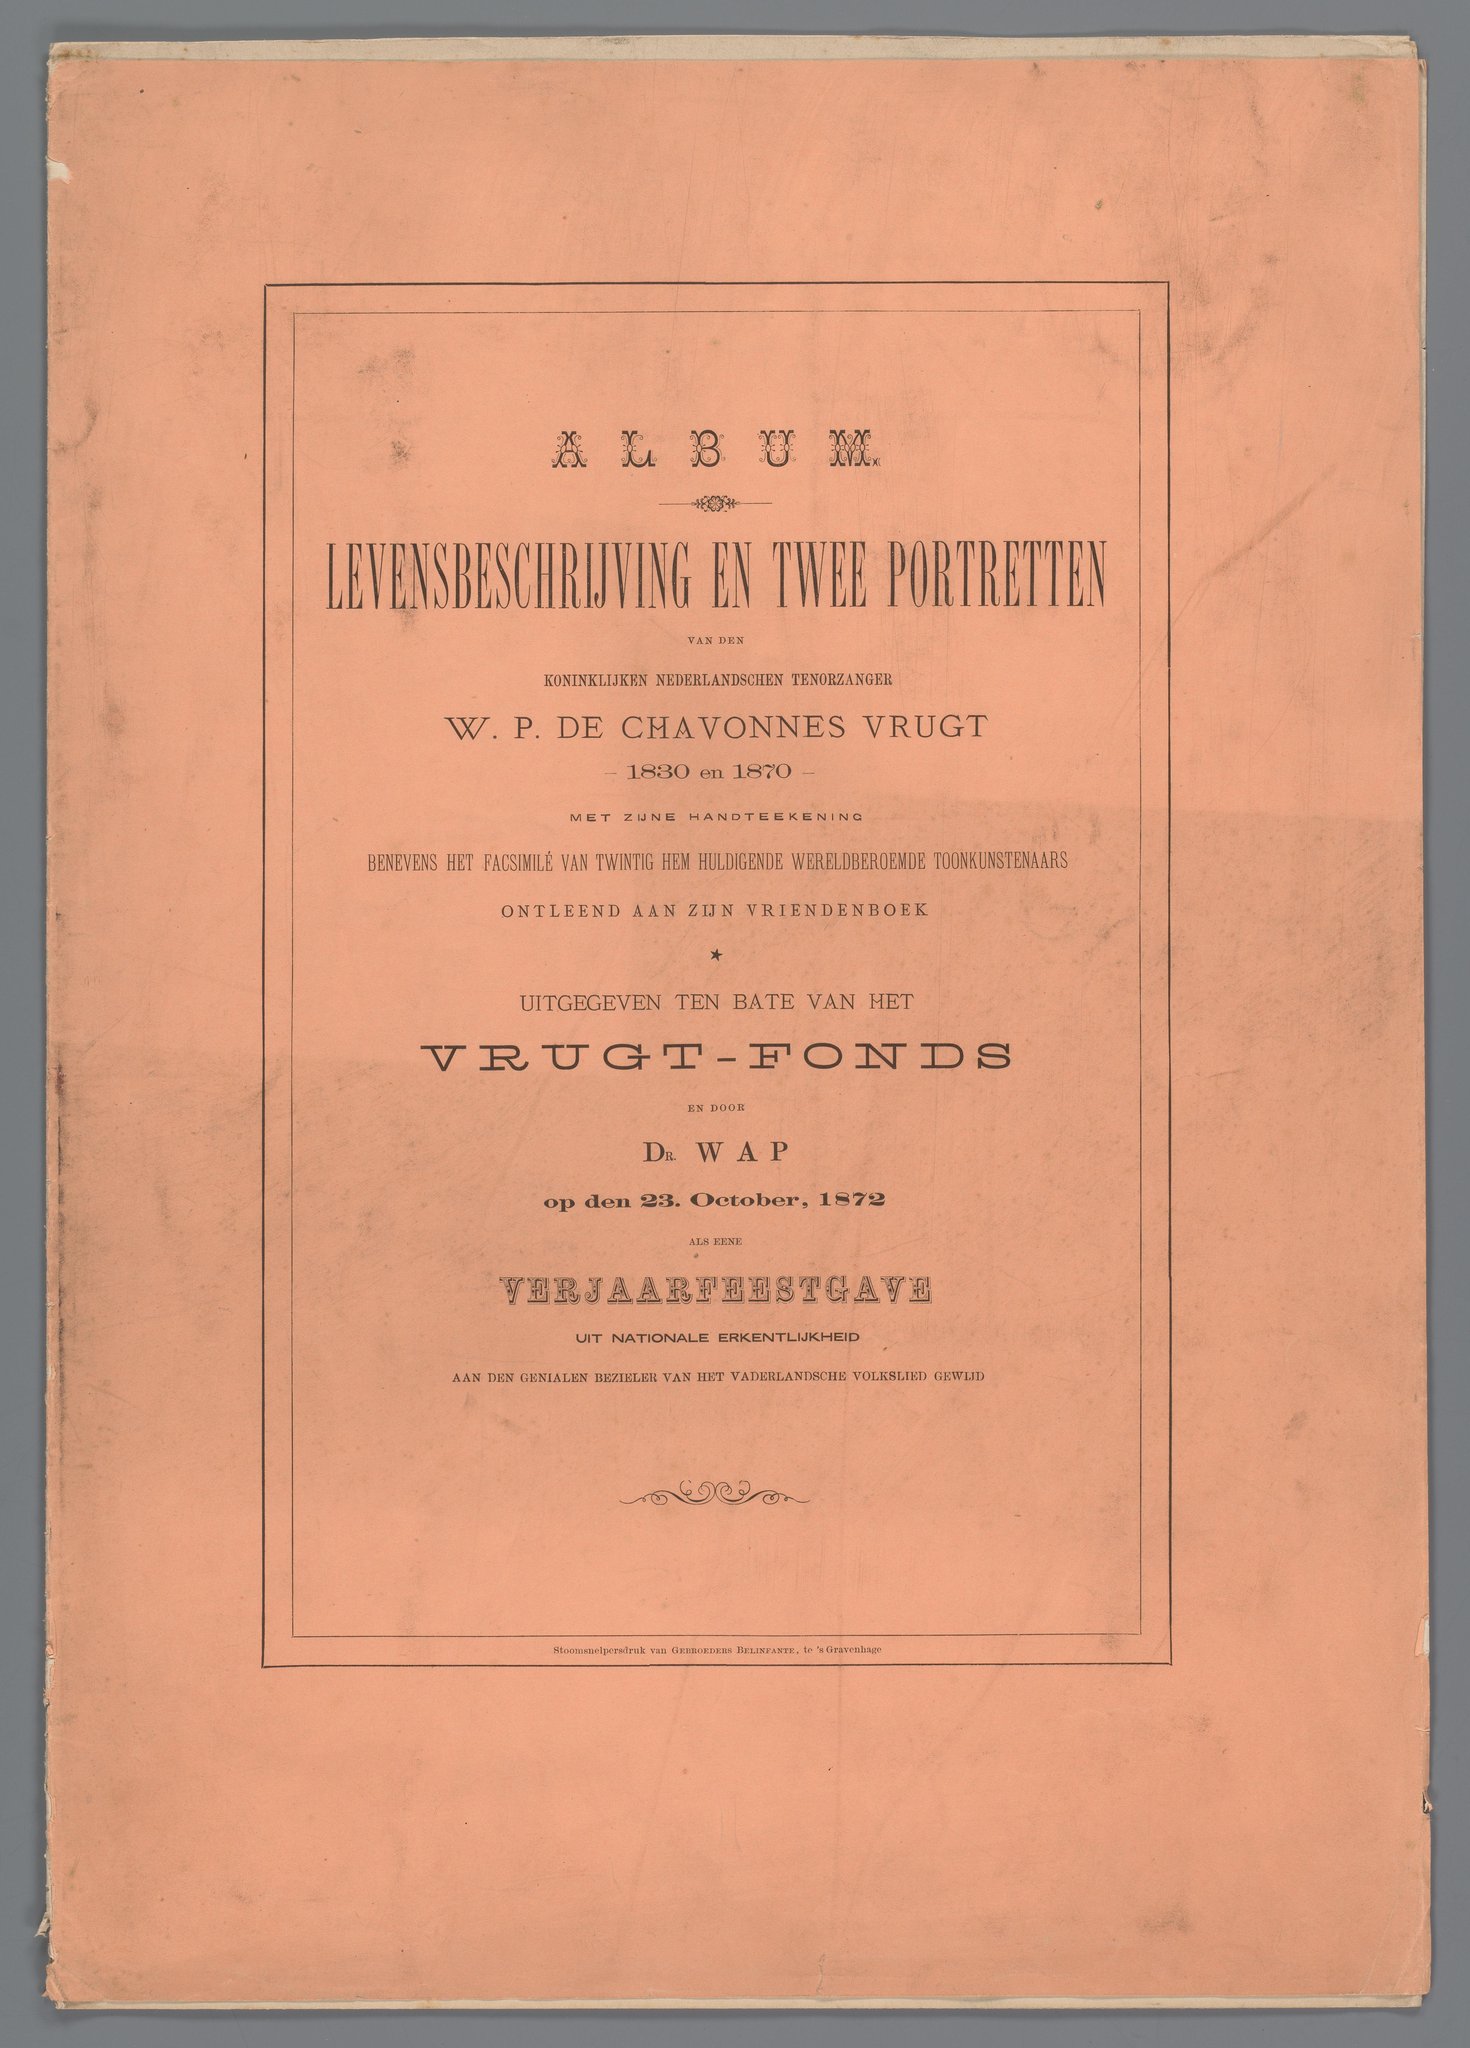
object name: wrapper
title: Omslag voor een tekstblad met levensbeschrijving en prent met twee portretten van Willem Pasques de Chavonnes Vrugt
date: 1872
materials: paper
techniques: letterpress printing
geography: the hague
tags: amsterdam, willem pasques de chavonnes vrugt, historical persons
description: Uitgegeven ter gelegenheid van de verjaardag van Willem Pasques de Chavonnes Vrugt.